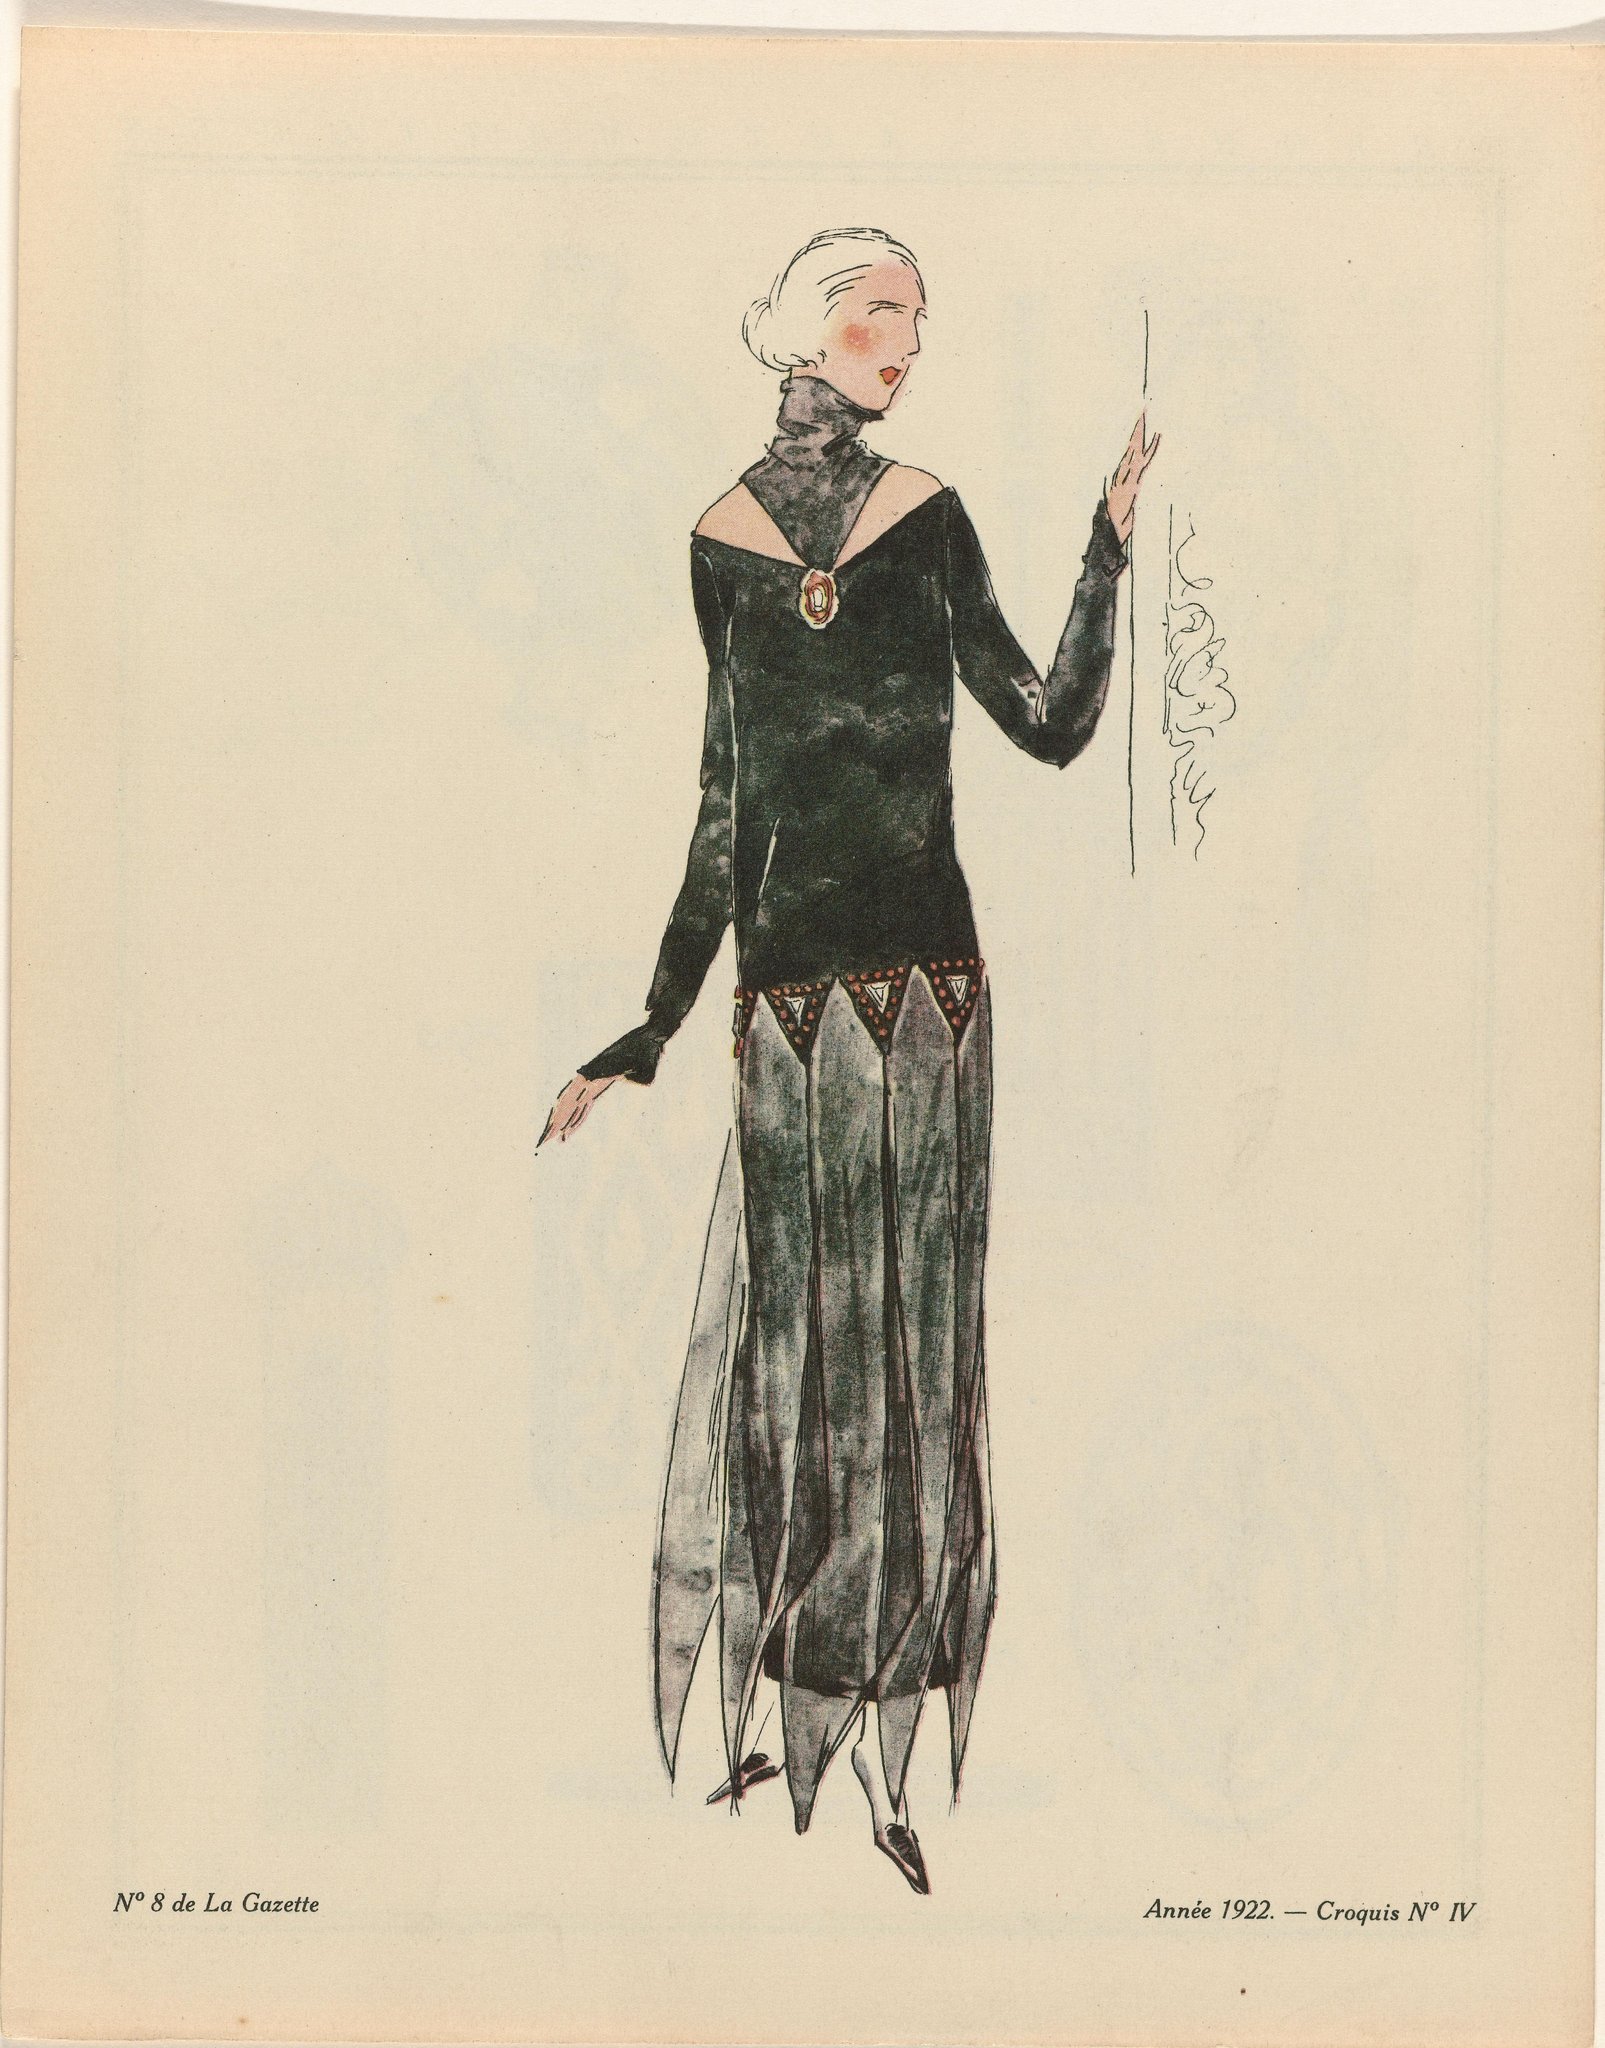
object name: fashion print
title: Gazette du Bon Ton, 1922 - No. 8 : Croquis No IV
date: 1922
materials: paper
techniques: printing, letterpress printing, photochemical processes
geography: new york city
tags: fashion plates, shoes, sandals (+ women's clothes), dress, gown (+ women's clothes), neck-gear ~ clothing (+ women's clothes)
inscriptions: date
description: Avondjapon met blote schouders en een hoge kraag. Bij de heupen een versiering van driehoeken, de rok met doorzichtige stroken. Croquis No IV uit Gazette du Bon Ton 1922, No. 8. Uitleg over de kleding op pagina "Description et explication des planches hors-texte et pages de croquis."